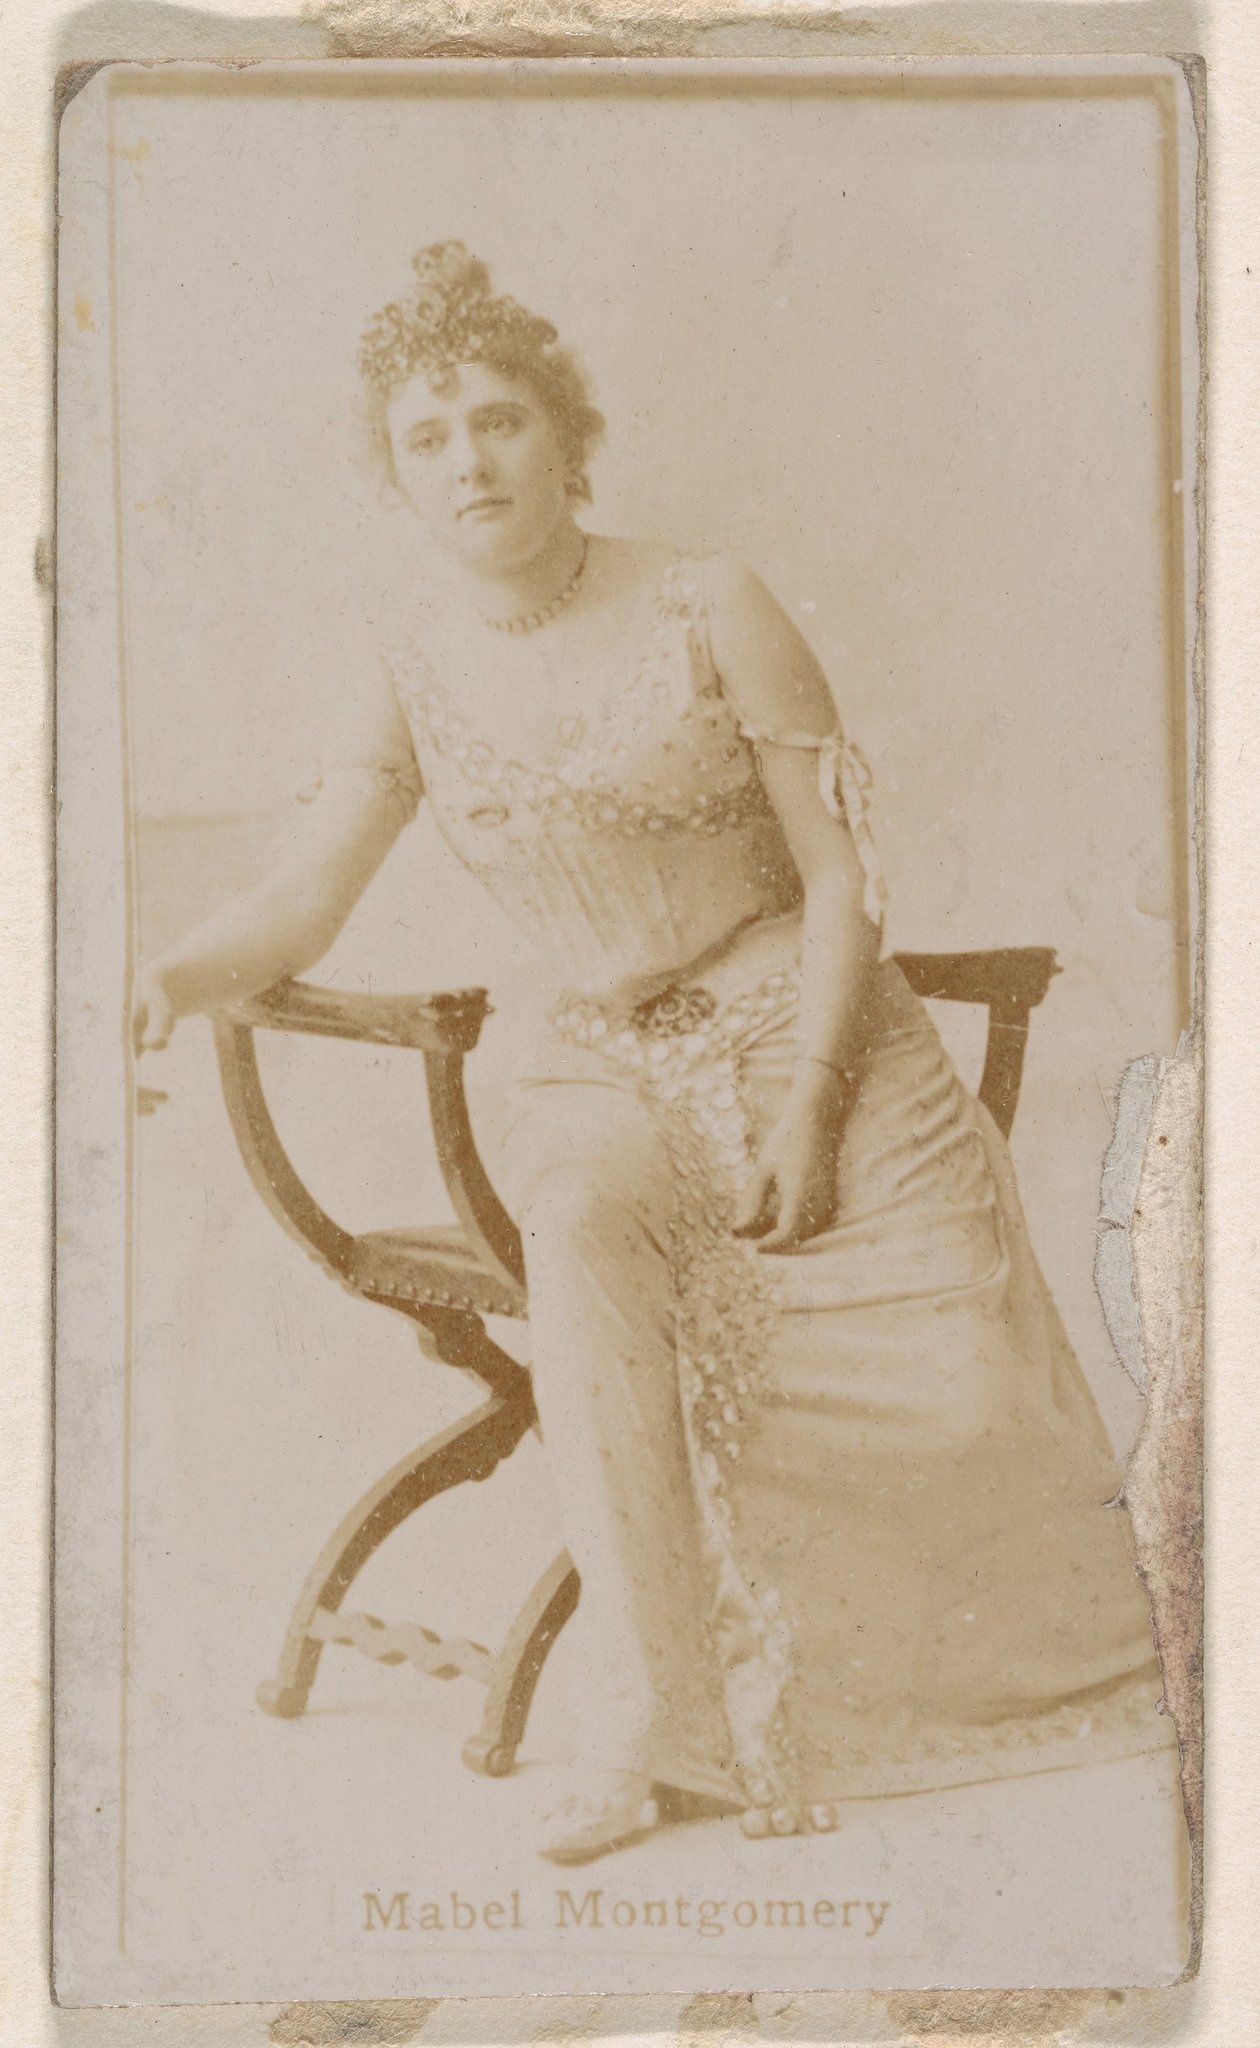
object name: photograph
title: Mabel Montgomery, from the Actresses series (N245) issued by Kinney Brothers to promote Sweet Caporal Cigarettes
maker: kinney brothers tobacco company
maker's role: publisher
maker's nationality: american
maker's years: 1869-2011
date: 1890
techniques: albumen silver print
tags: portraits,women,actresses